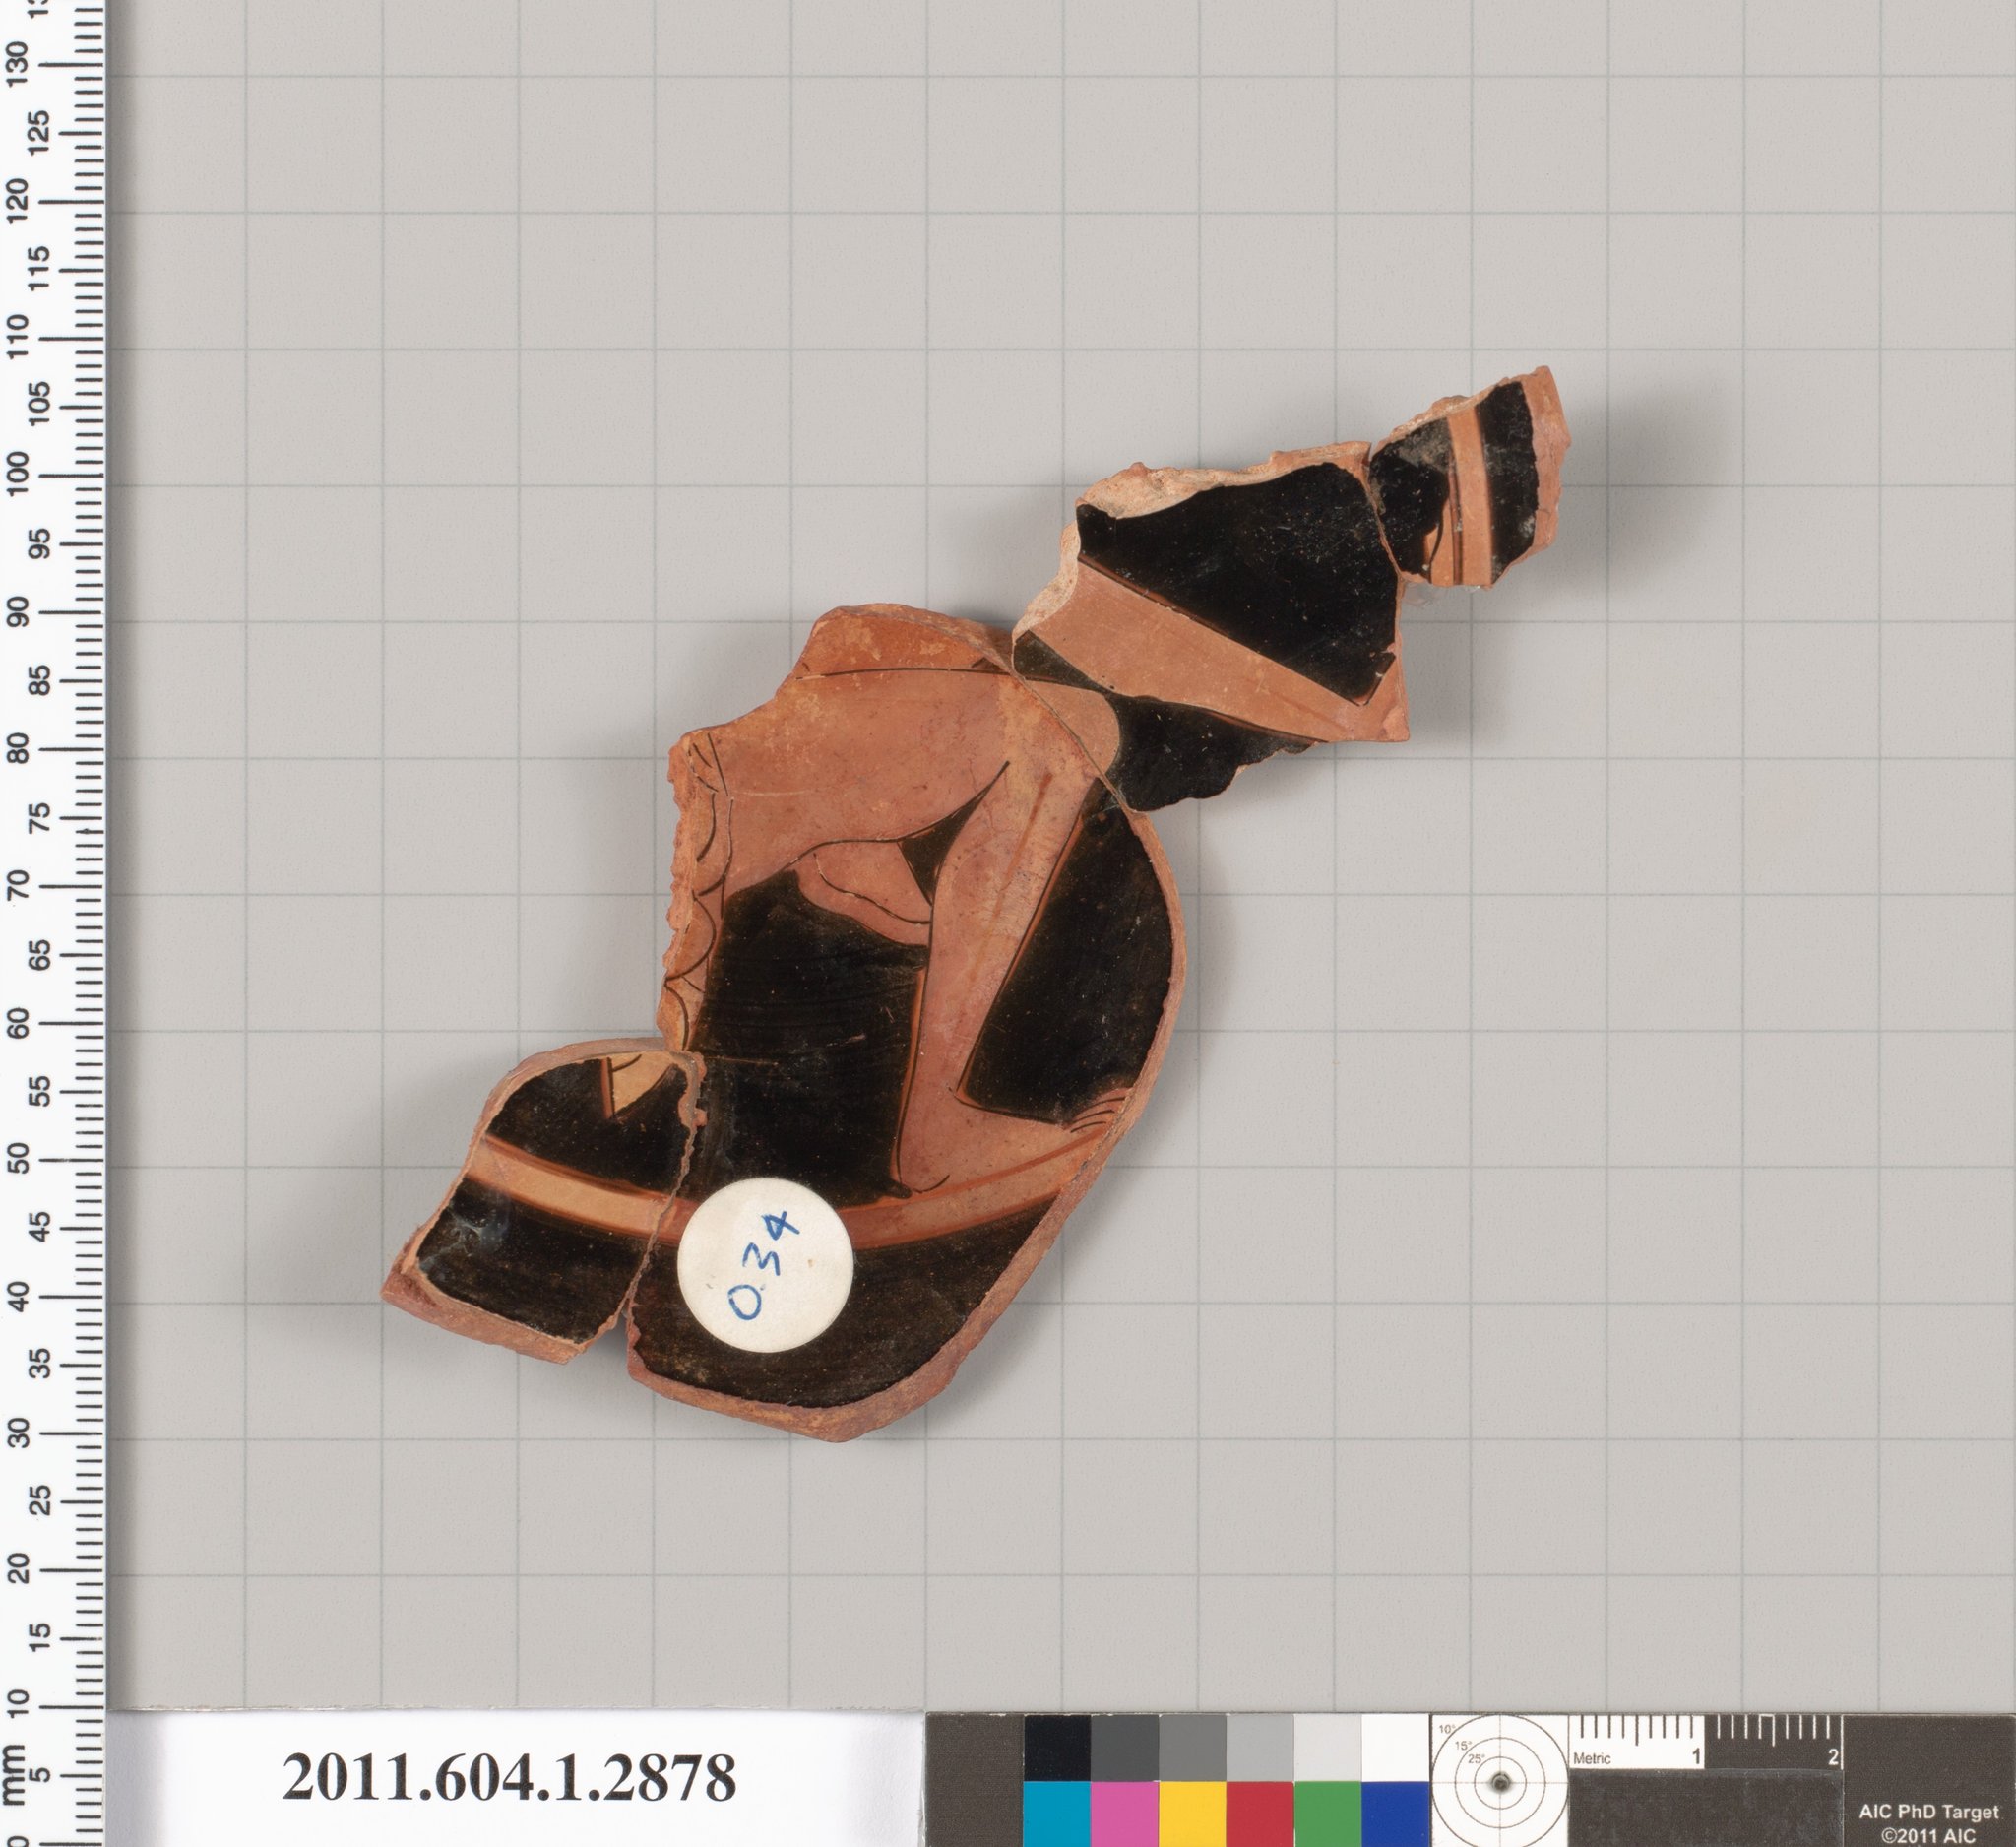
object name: kylix fragment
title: Terracotta fragment of a kylix (drinking cup)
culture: greek, attic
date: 510-490 BCE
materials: terracotta